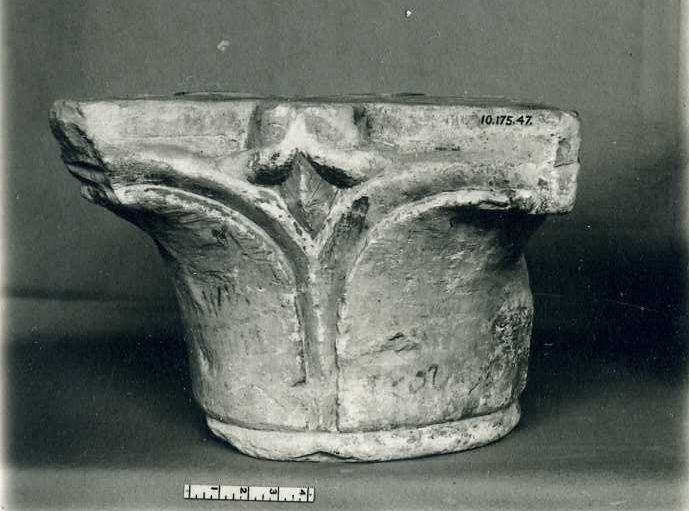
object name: capital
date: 501-700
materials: limestone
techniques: carving, relief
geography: egypt